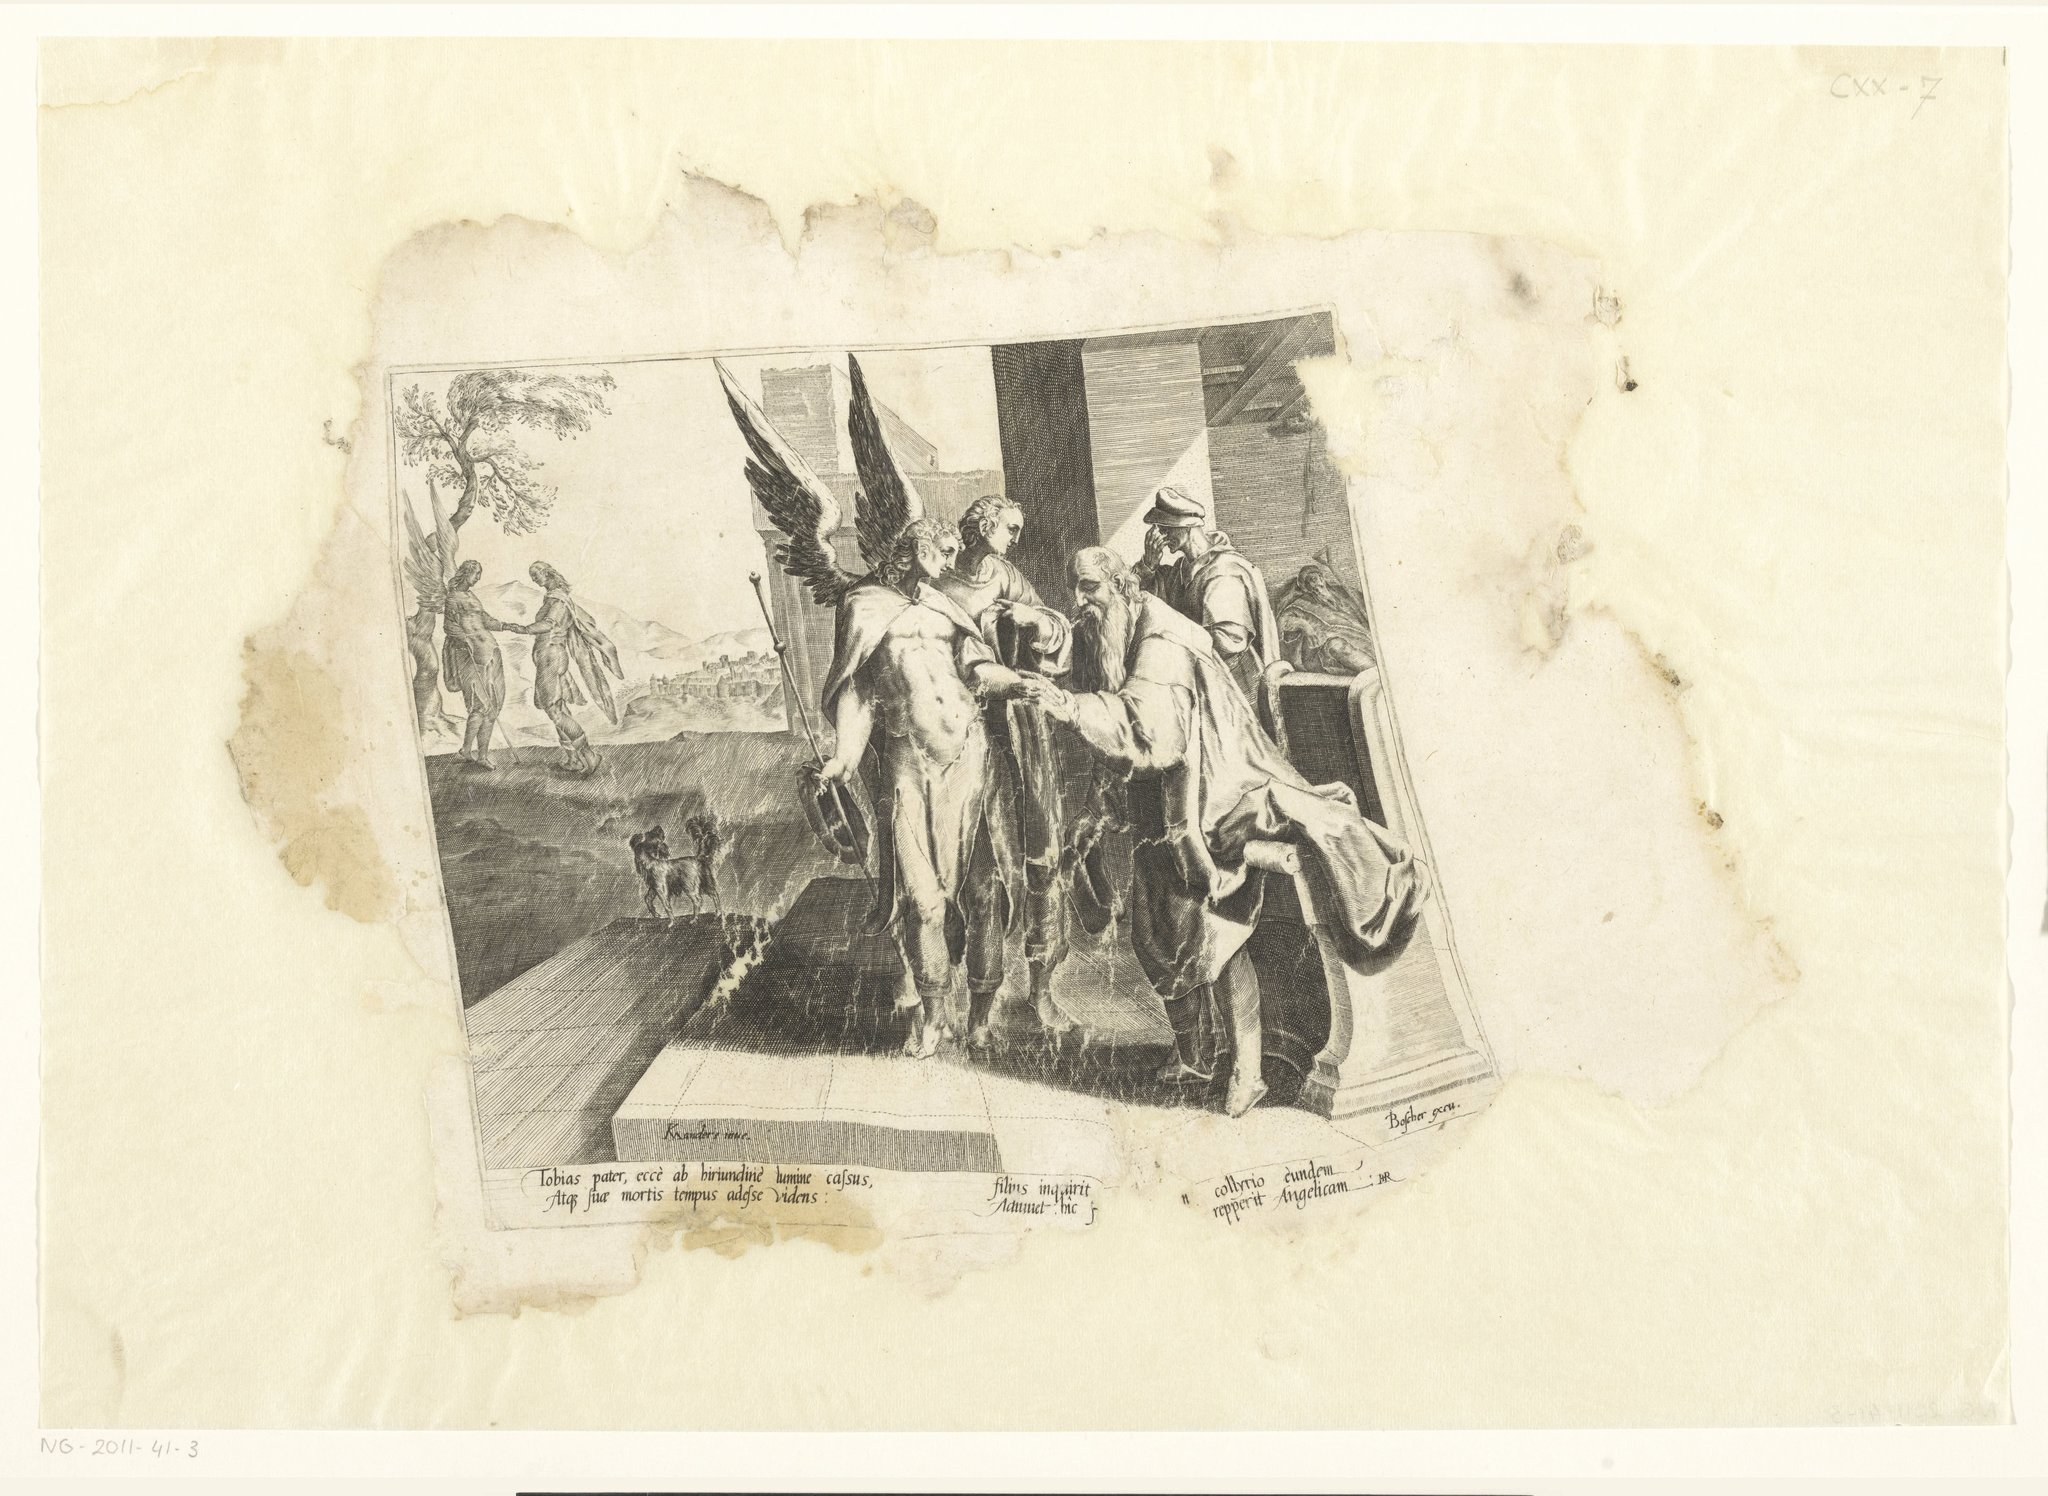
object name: print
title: Afscheid van Tobias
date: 1580-1596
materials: paper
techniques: engraving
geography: amsterdam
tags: tobias taking leave of his parents; anna mourns her son's departure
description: De prenten in de Nova Zembla collectie zijn tijdens een expeditie van Willem Barendsz en Jacob van Heemskerk in 1596-1597 noodgedwongen in het winterkamp, het ‘Behouden Huis’, op het eiland achtergelaten. De prenten waren in één of meerdere stapels als handelswaar meegenomen vanuit Amsterdam. Bijna drie eeuwen later, in 1871, keerde de Noor Elling Carlsen terug naar Nova Zembla en vond daar de restanten van het ‘Behouden Huis, inclusief een groot deel van de inventaris. Een deel van de prenten, in de vorm van aaneengekoekte kluiten, werd toen ook teruggevonden. De papierkluiten waren soms op meerdere plekken gebroken. Tussen 1975-1979 zijn de prenten van elkaar gescheiden. Dit leverde in totaal ca. 1000 fragmenten van ca. 400 afdrukken van ca. 150 verschillende prenten op. Voor zover mogelijk zijn de fragmenten samengevoegd en zijn de prenten gereconstrueerd.